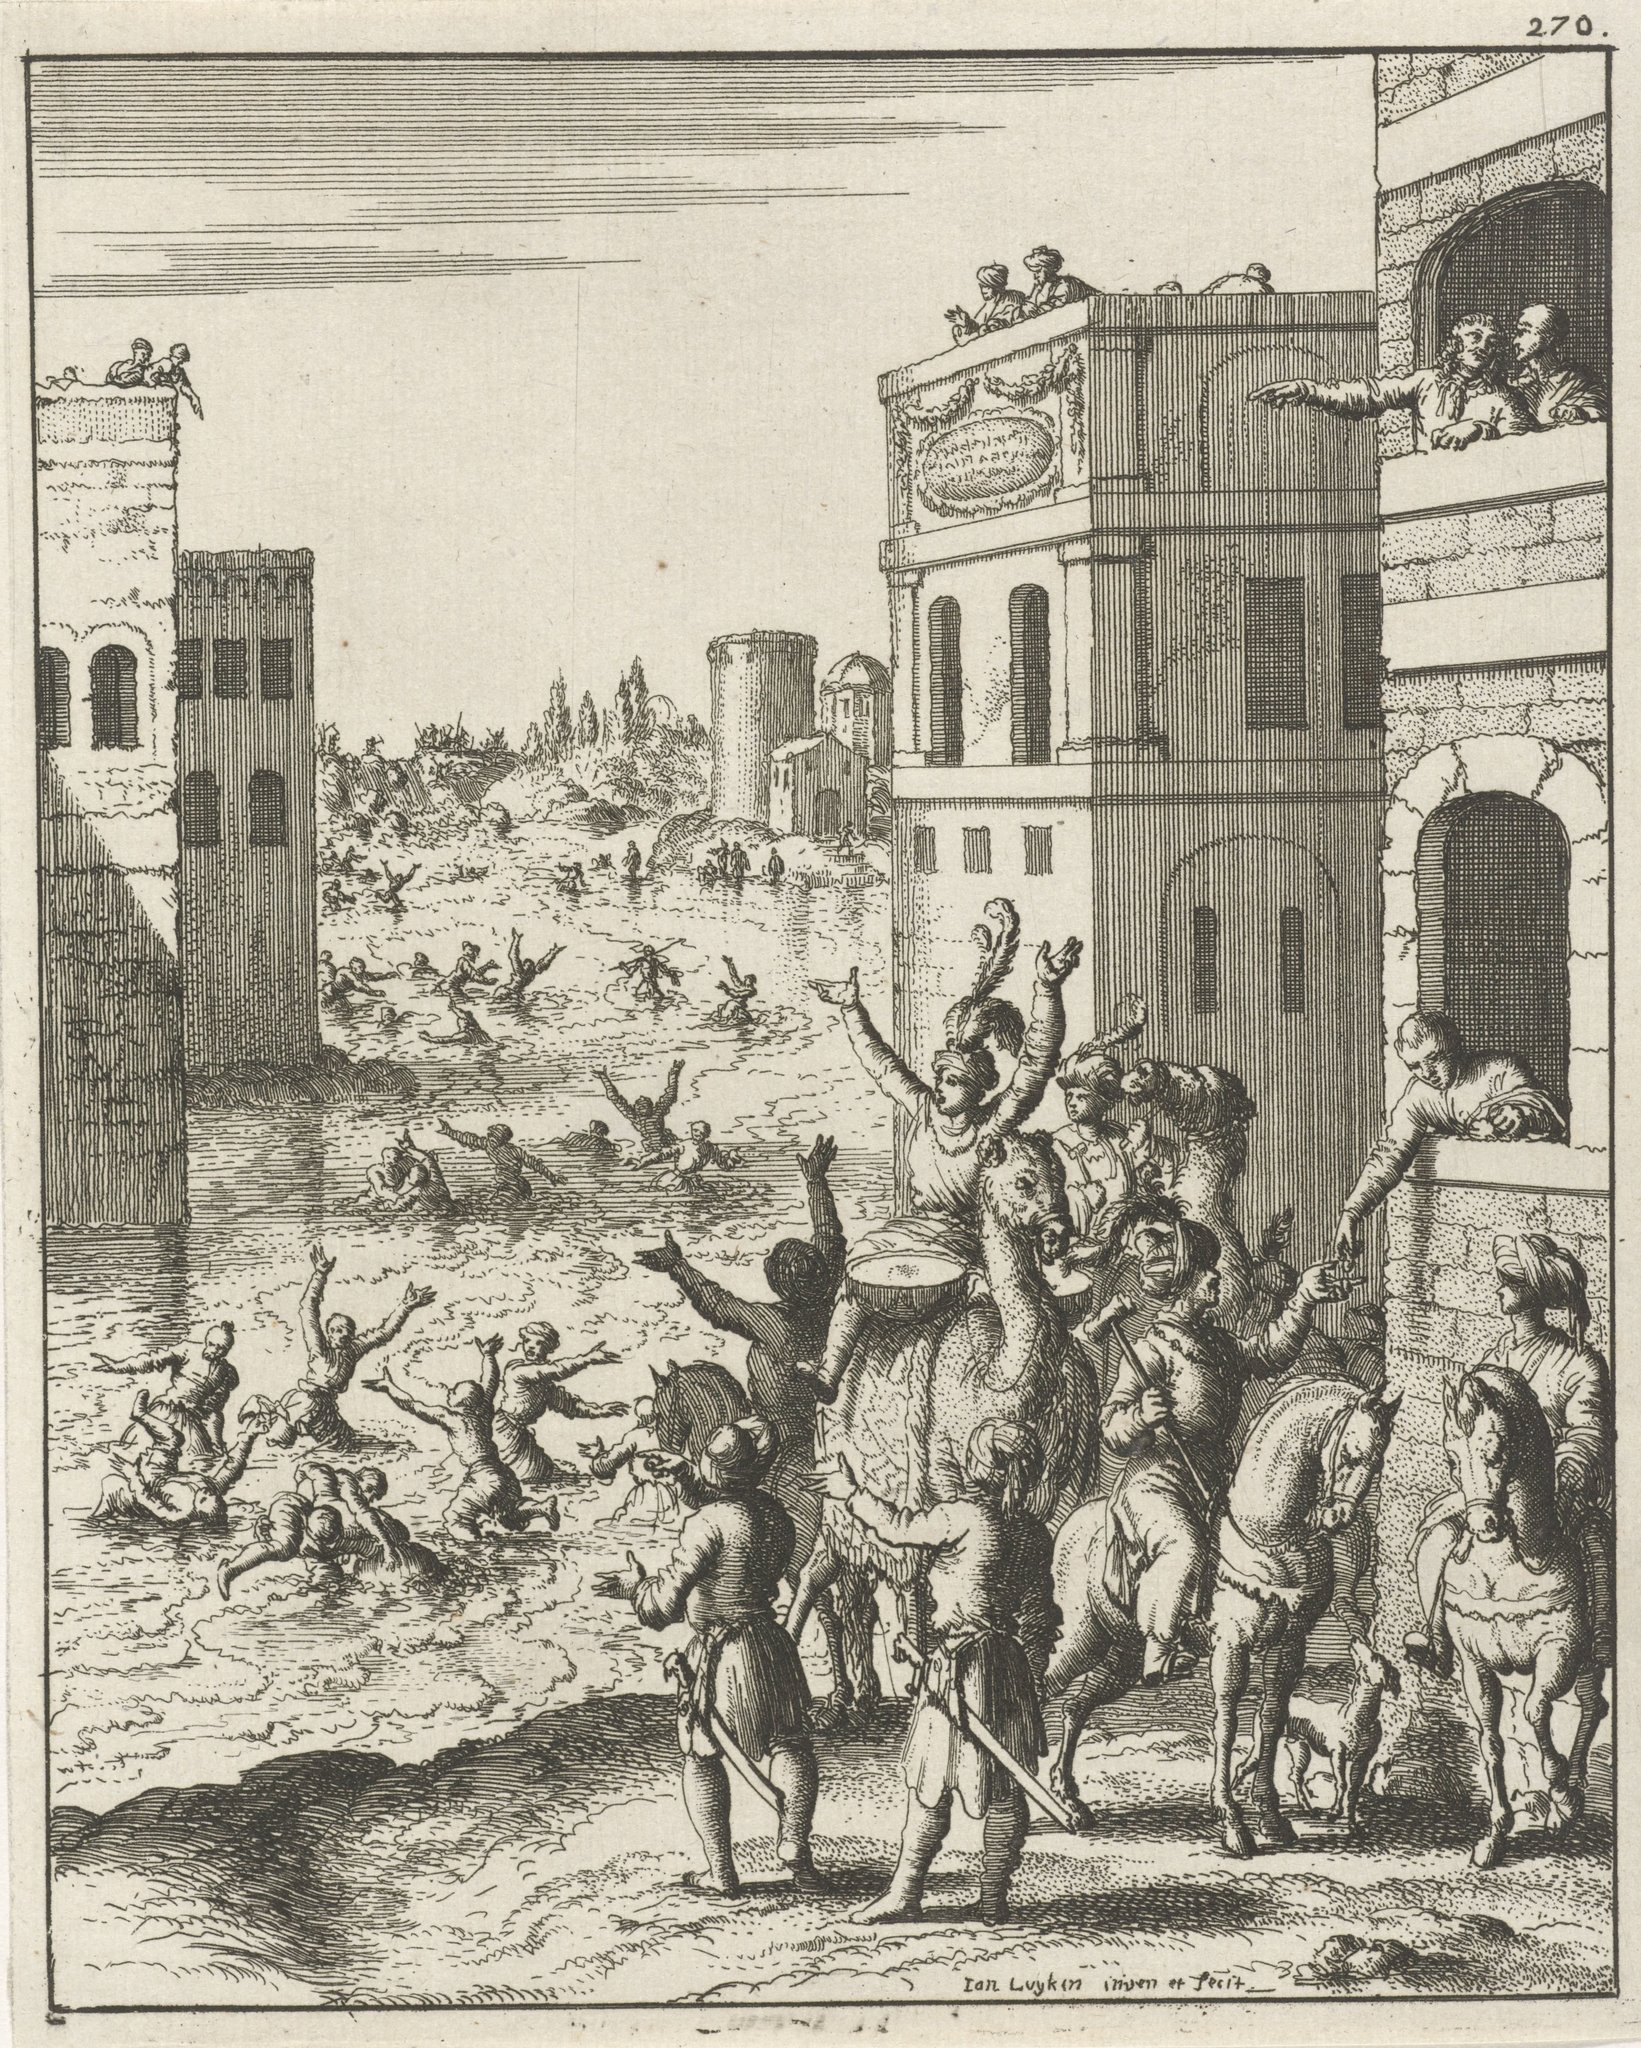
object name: book illustration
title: Vreugdebetoon van het volk in Caïro bij het doorsteken van de Nijldijk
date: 1681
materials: paper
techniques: etching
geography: amsterdam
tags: dikes, levee, rejoicing on special occasions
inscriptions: collector's mark: Lugt 2228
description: Illustratie opgenomen in deel I van: Thevenot, Jean de. Gedenkwaardige en zeer naauwkeurige reizen van den heere de Thevenot. Amsterdam: Jan Bouman, 1681-1682.